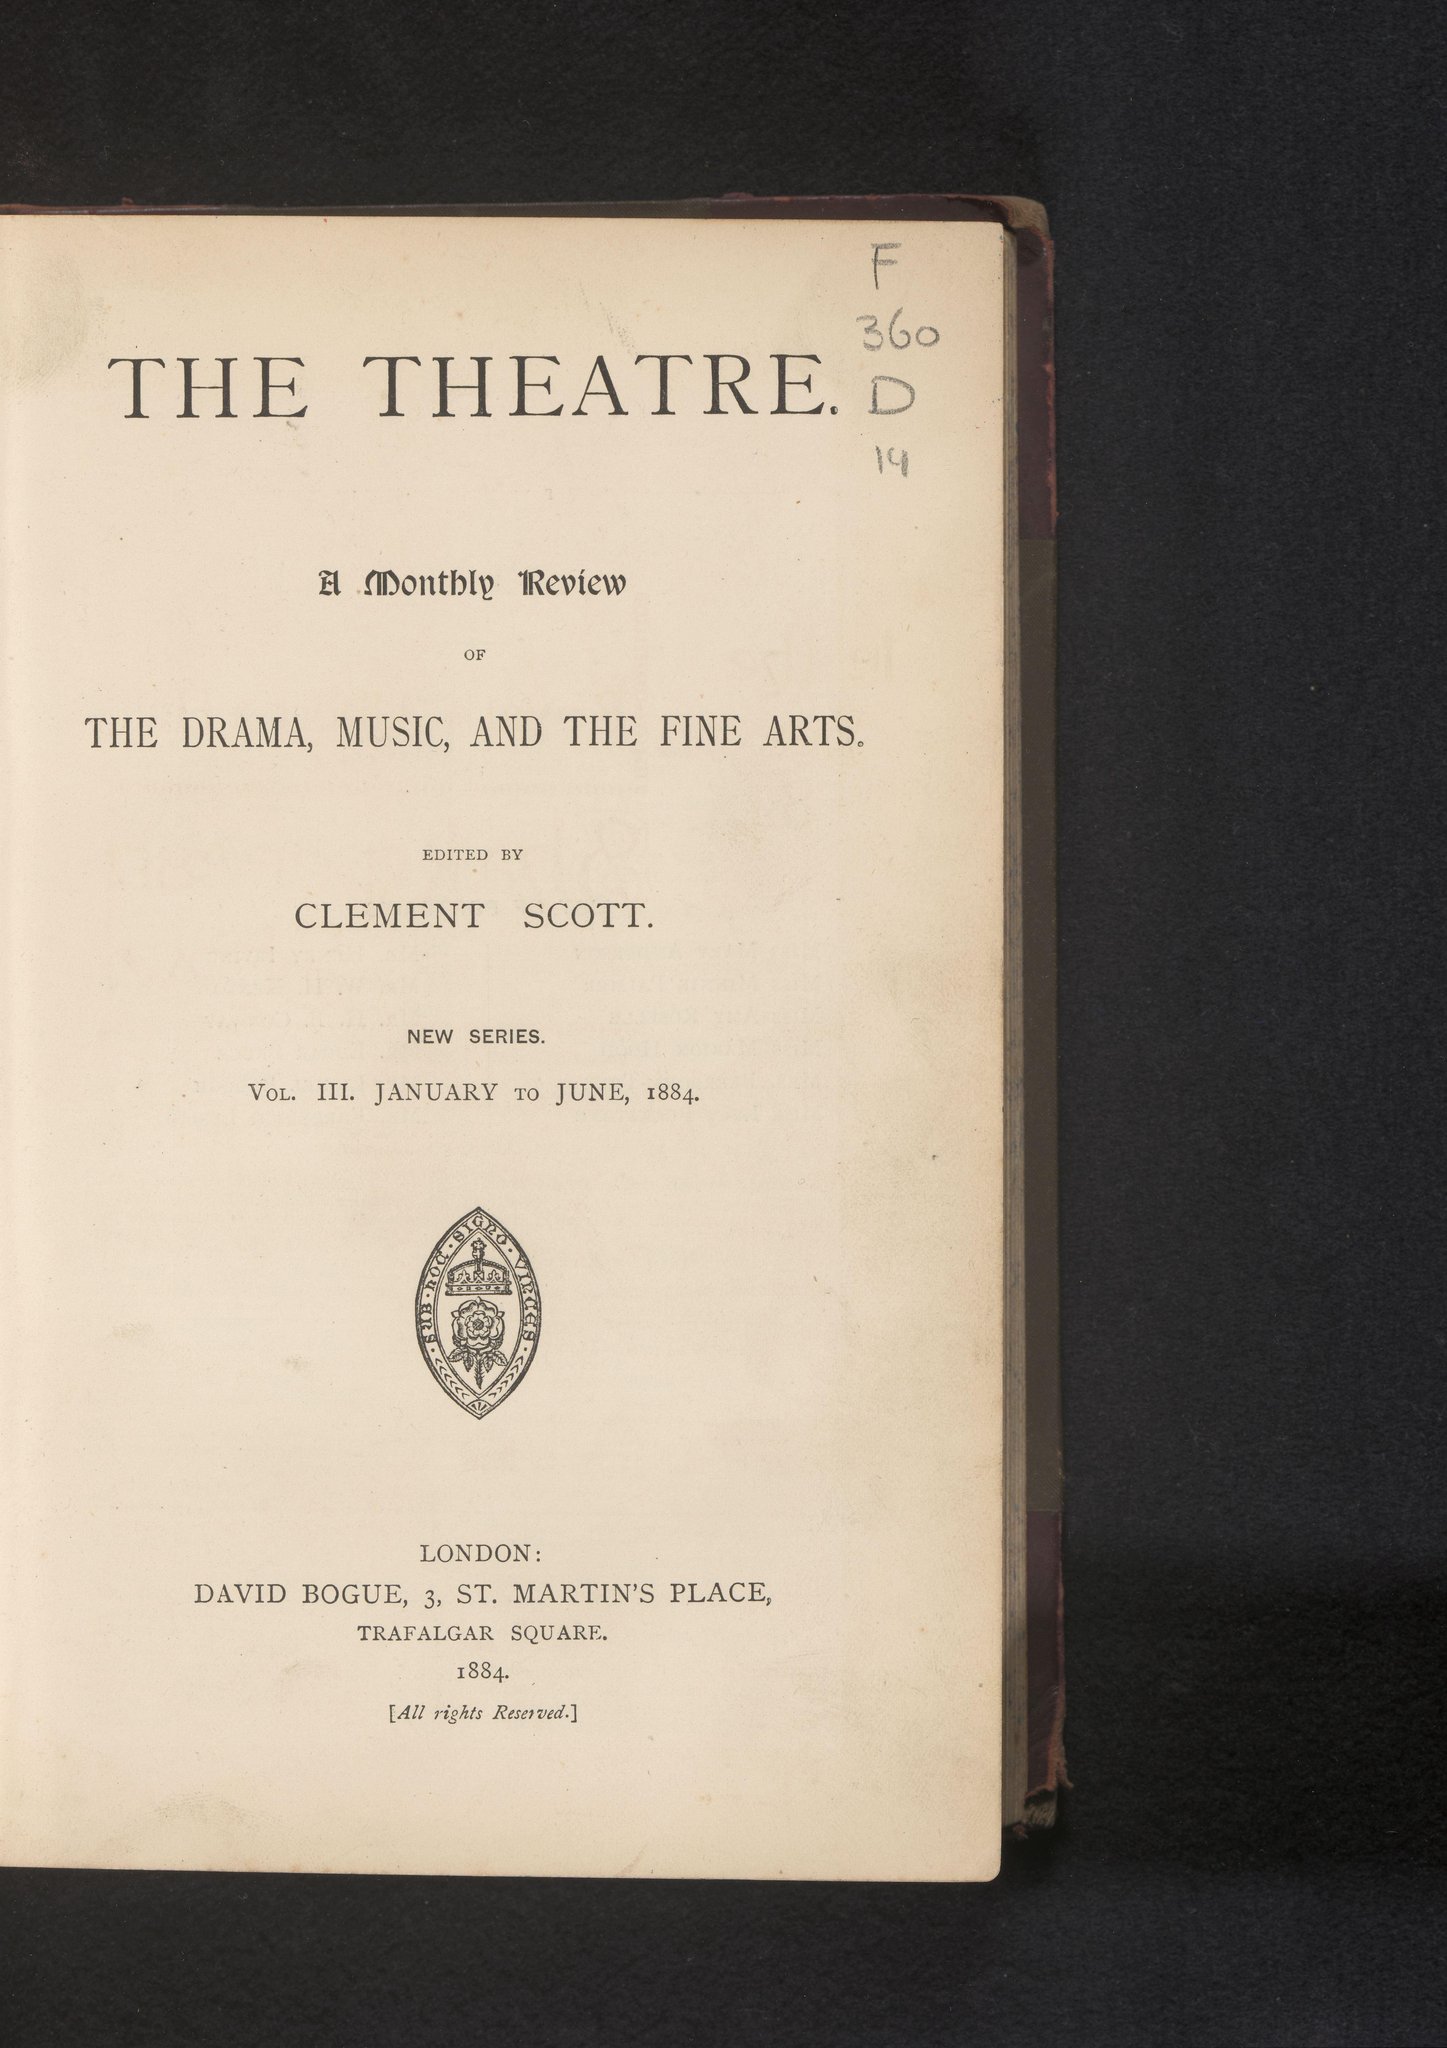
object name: magazine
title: The theatre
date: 1884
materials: leather, paper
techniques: printing, woodburytype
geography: london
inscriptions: bookplate: ‘Ex SFJ Libris’, annotation: ‘APR 1983’, annotation: ‘allan Mc. Lean/ Alexandria/ Dec 1 1884’